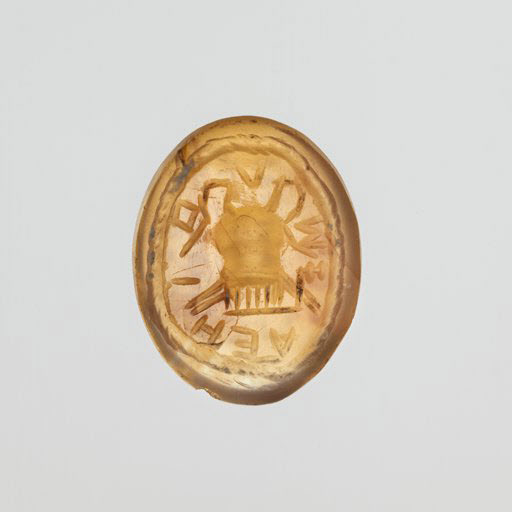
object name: intaglio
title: Agate intaglio: Uterine symbol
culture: roman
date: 101-200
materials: stone